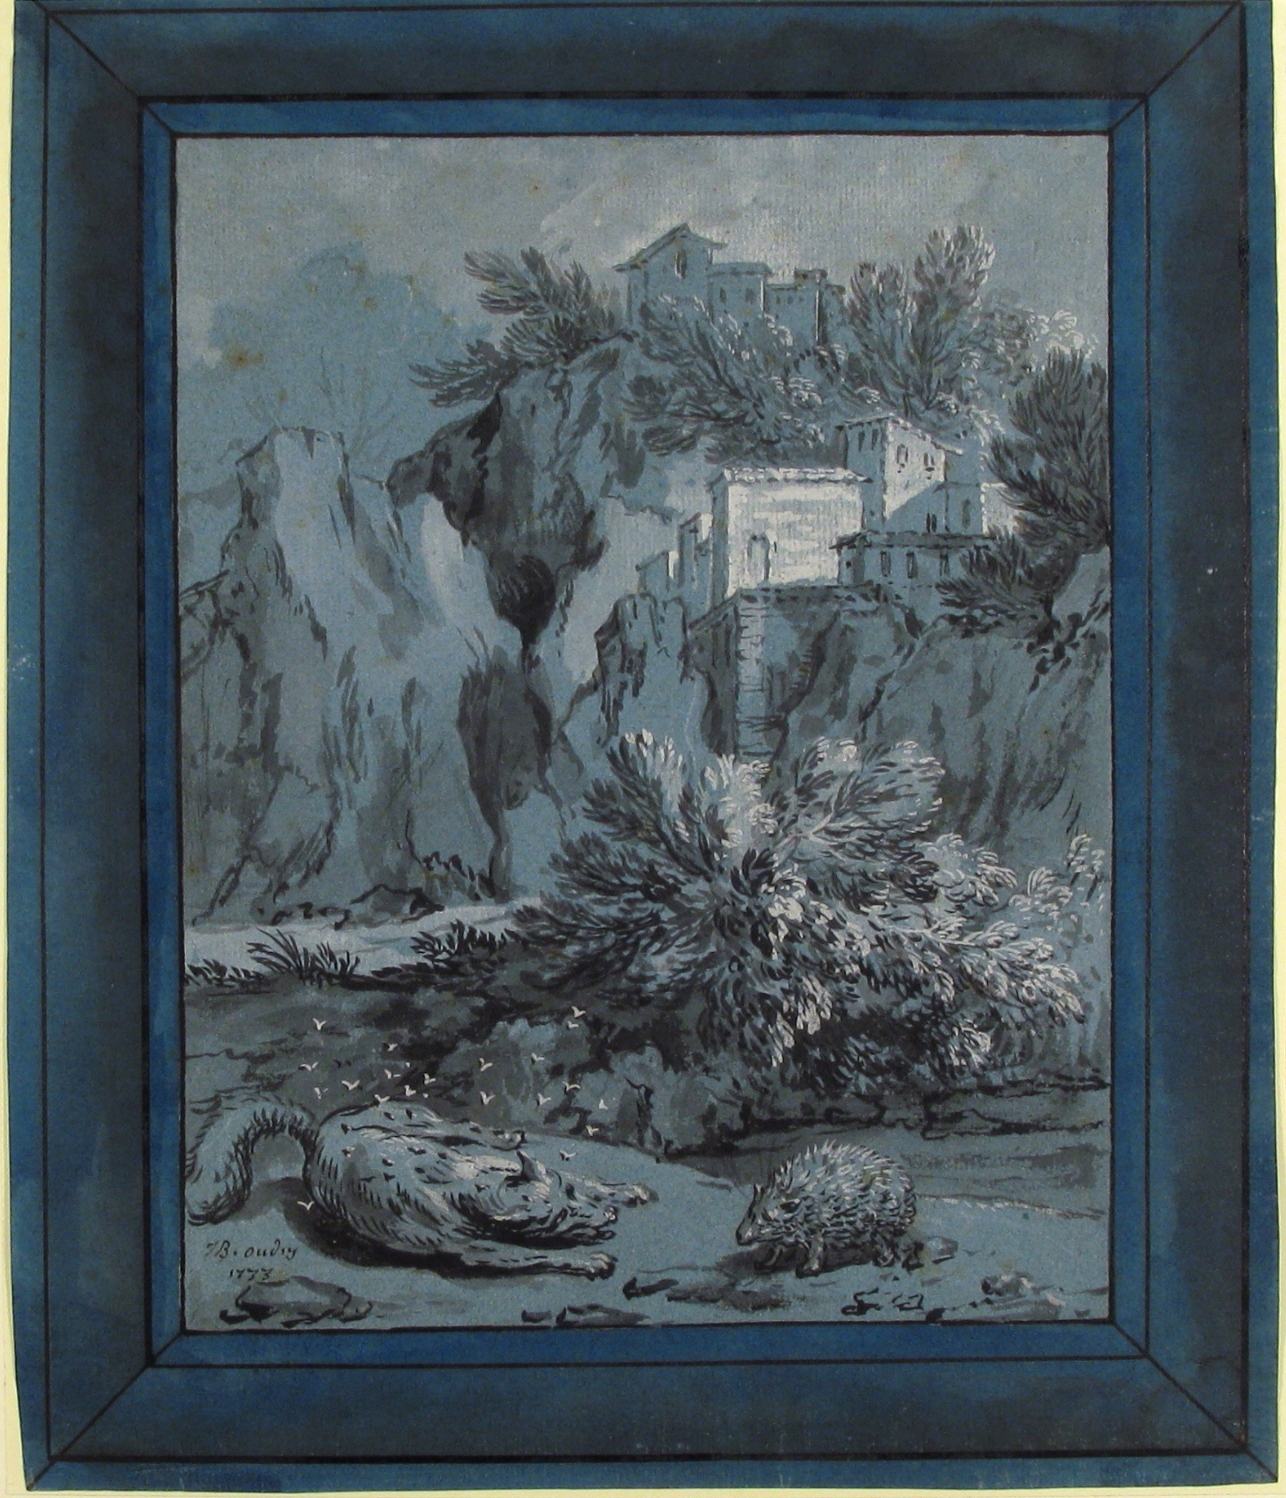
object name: drawing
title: The Fox, the Flies, and the Hedgehog, from La Fontaine's "Fables", XII, 13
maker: jean-baptiste oudry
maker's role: artist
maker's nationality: french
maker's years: 1686-1755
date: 1733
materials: ink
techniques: brush, heightening, wash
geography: france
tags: animals,buildings,foxes,trees